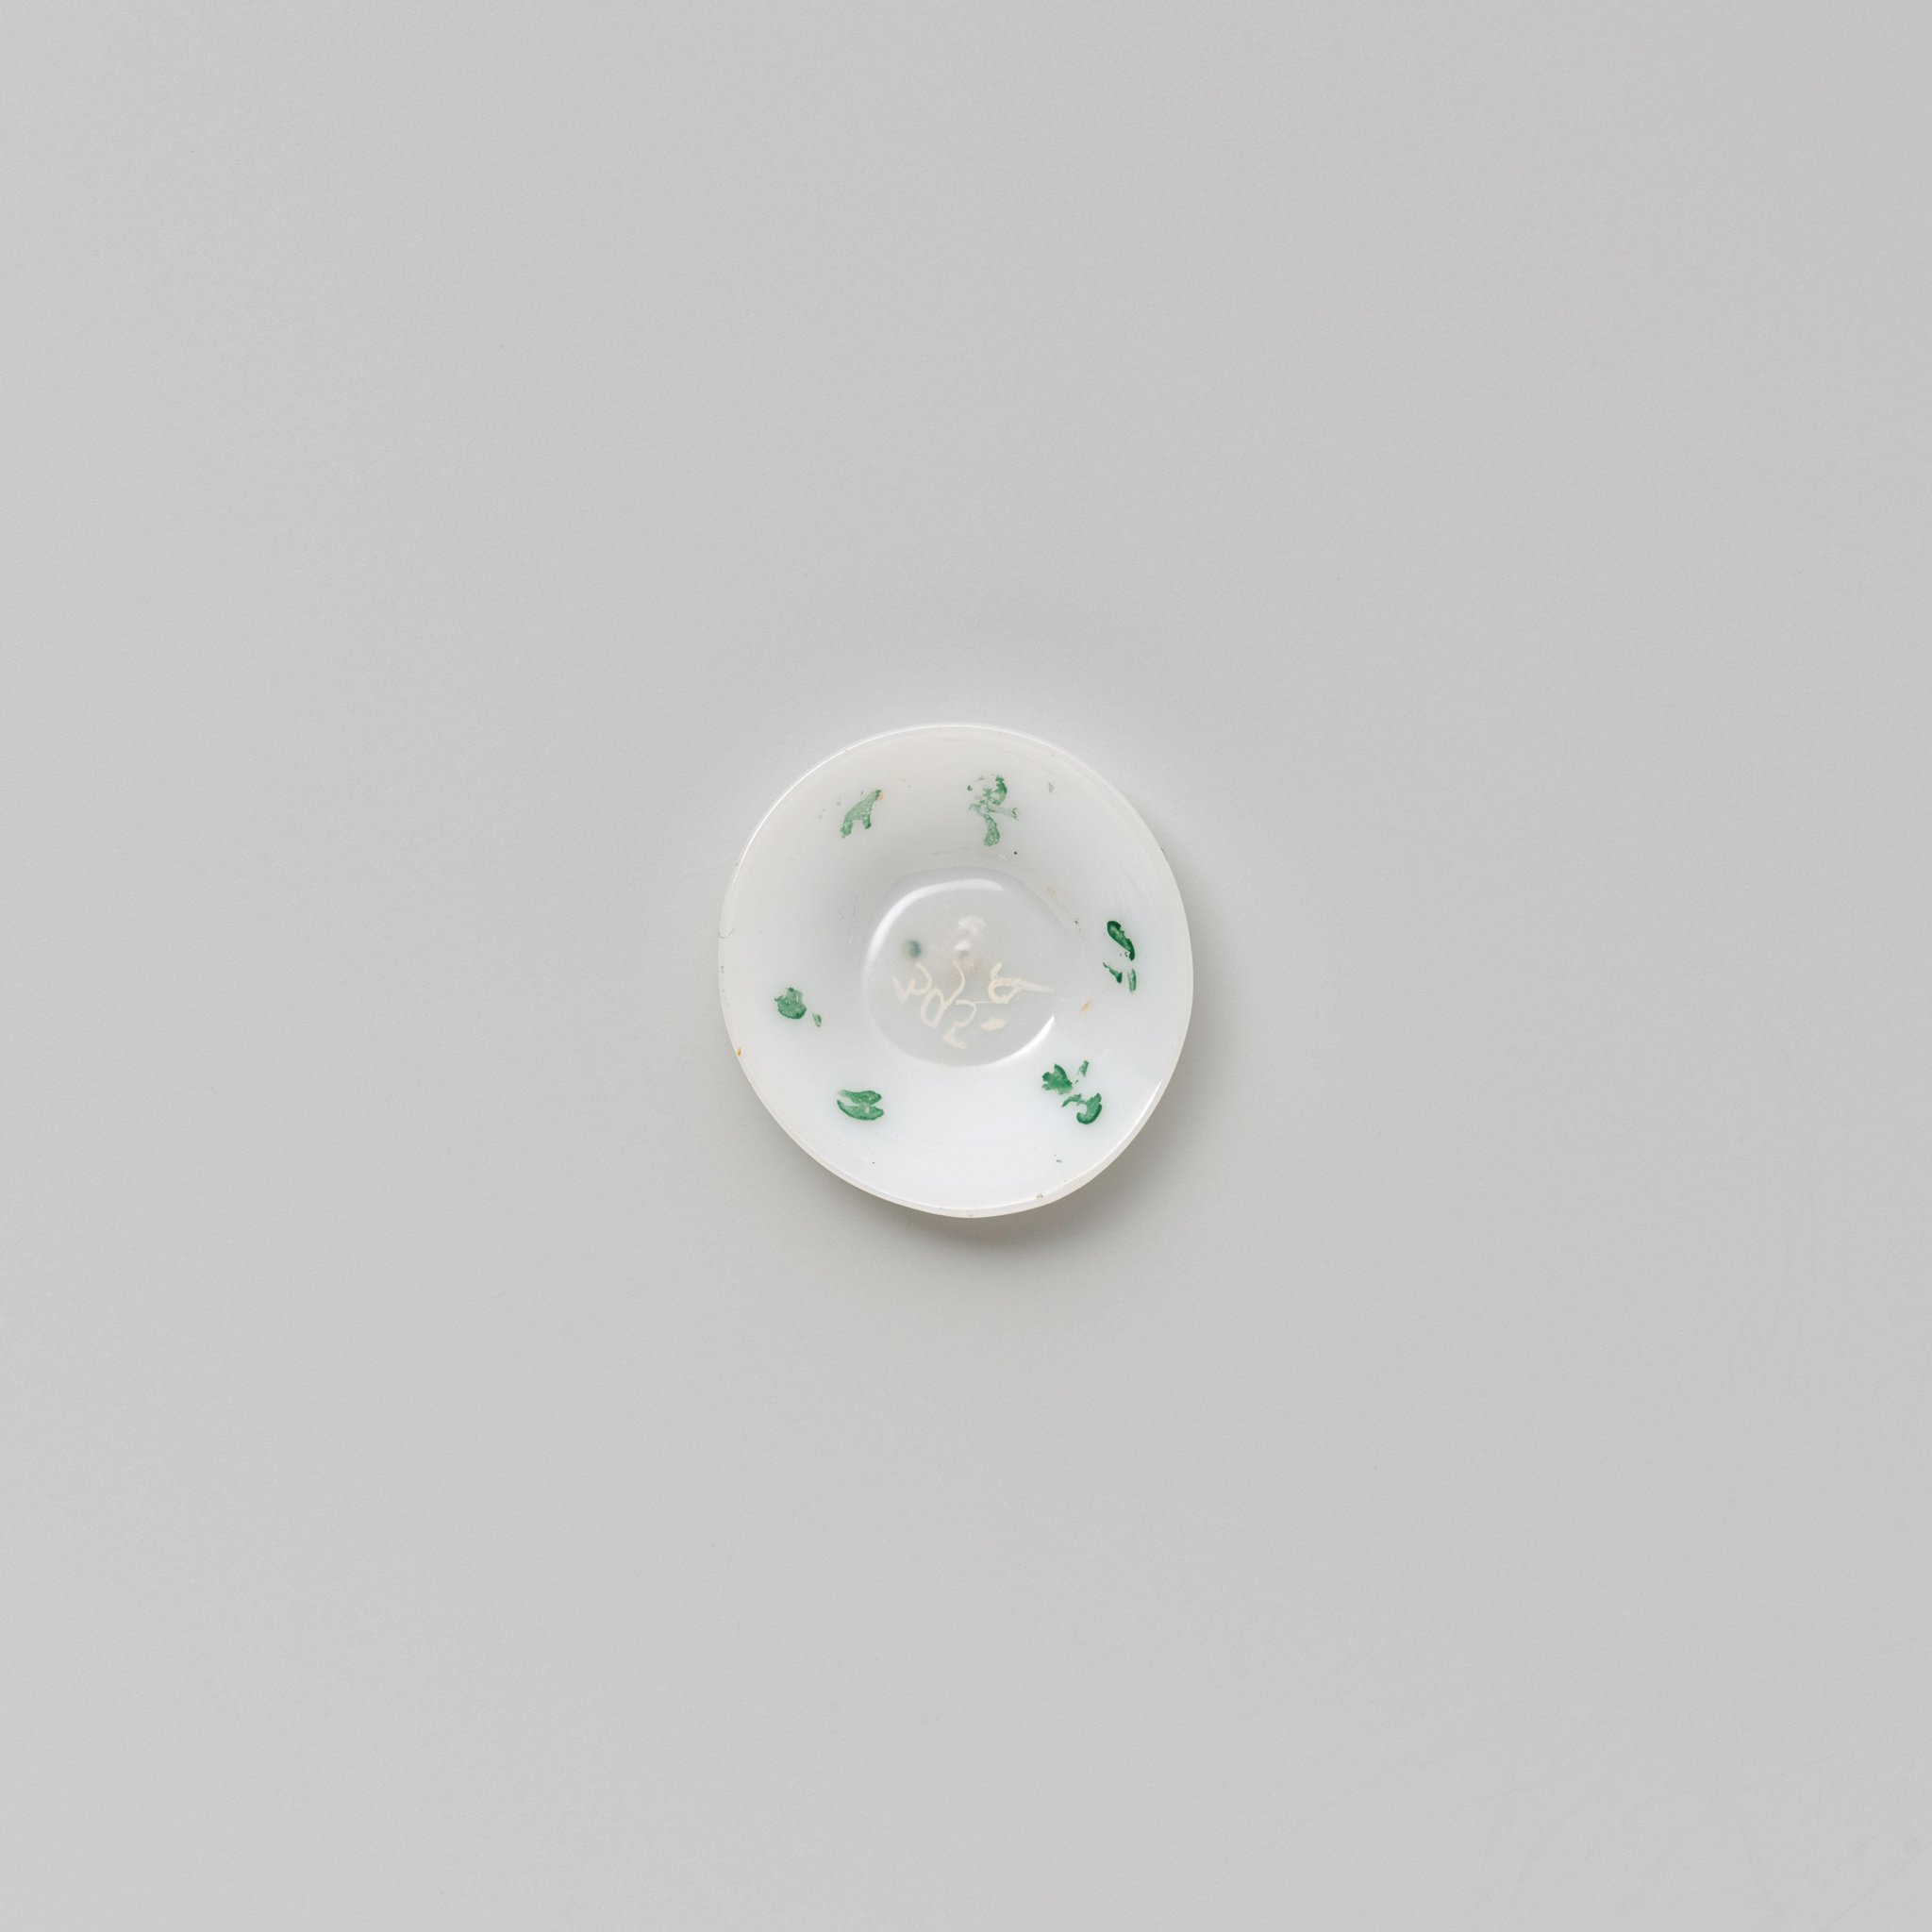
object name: miniature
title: Schotel, beschilderd met bloemen in wit, groen en rood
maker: Anonymous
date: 1800-1849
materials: glass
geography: bristol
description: Schotel van opaak wit glas, met brede schuin opstaande rand, beschilderd met bloemenin wit, groen en rood.